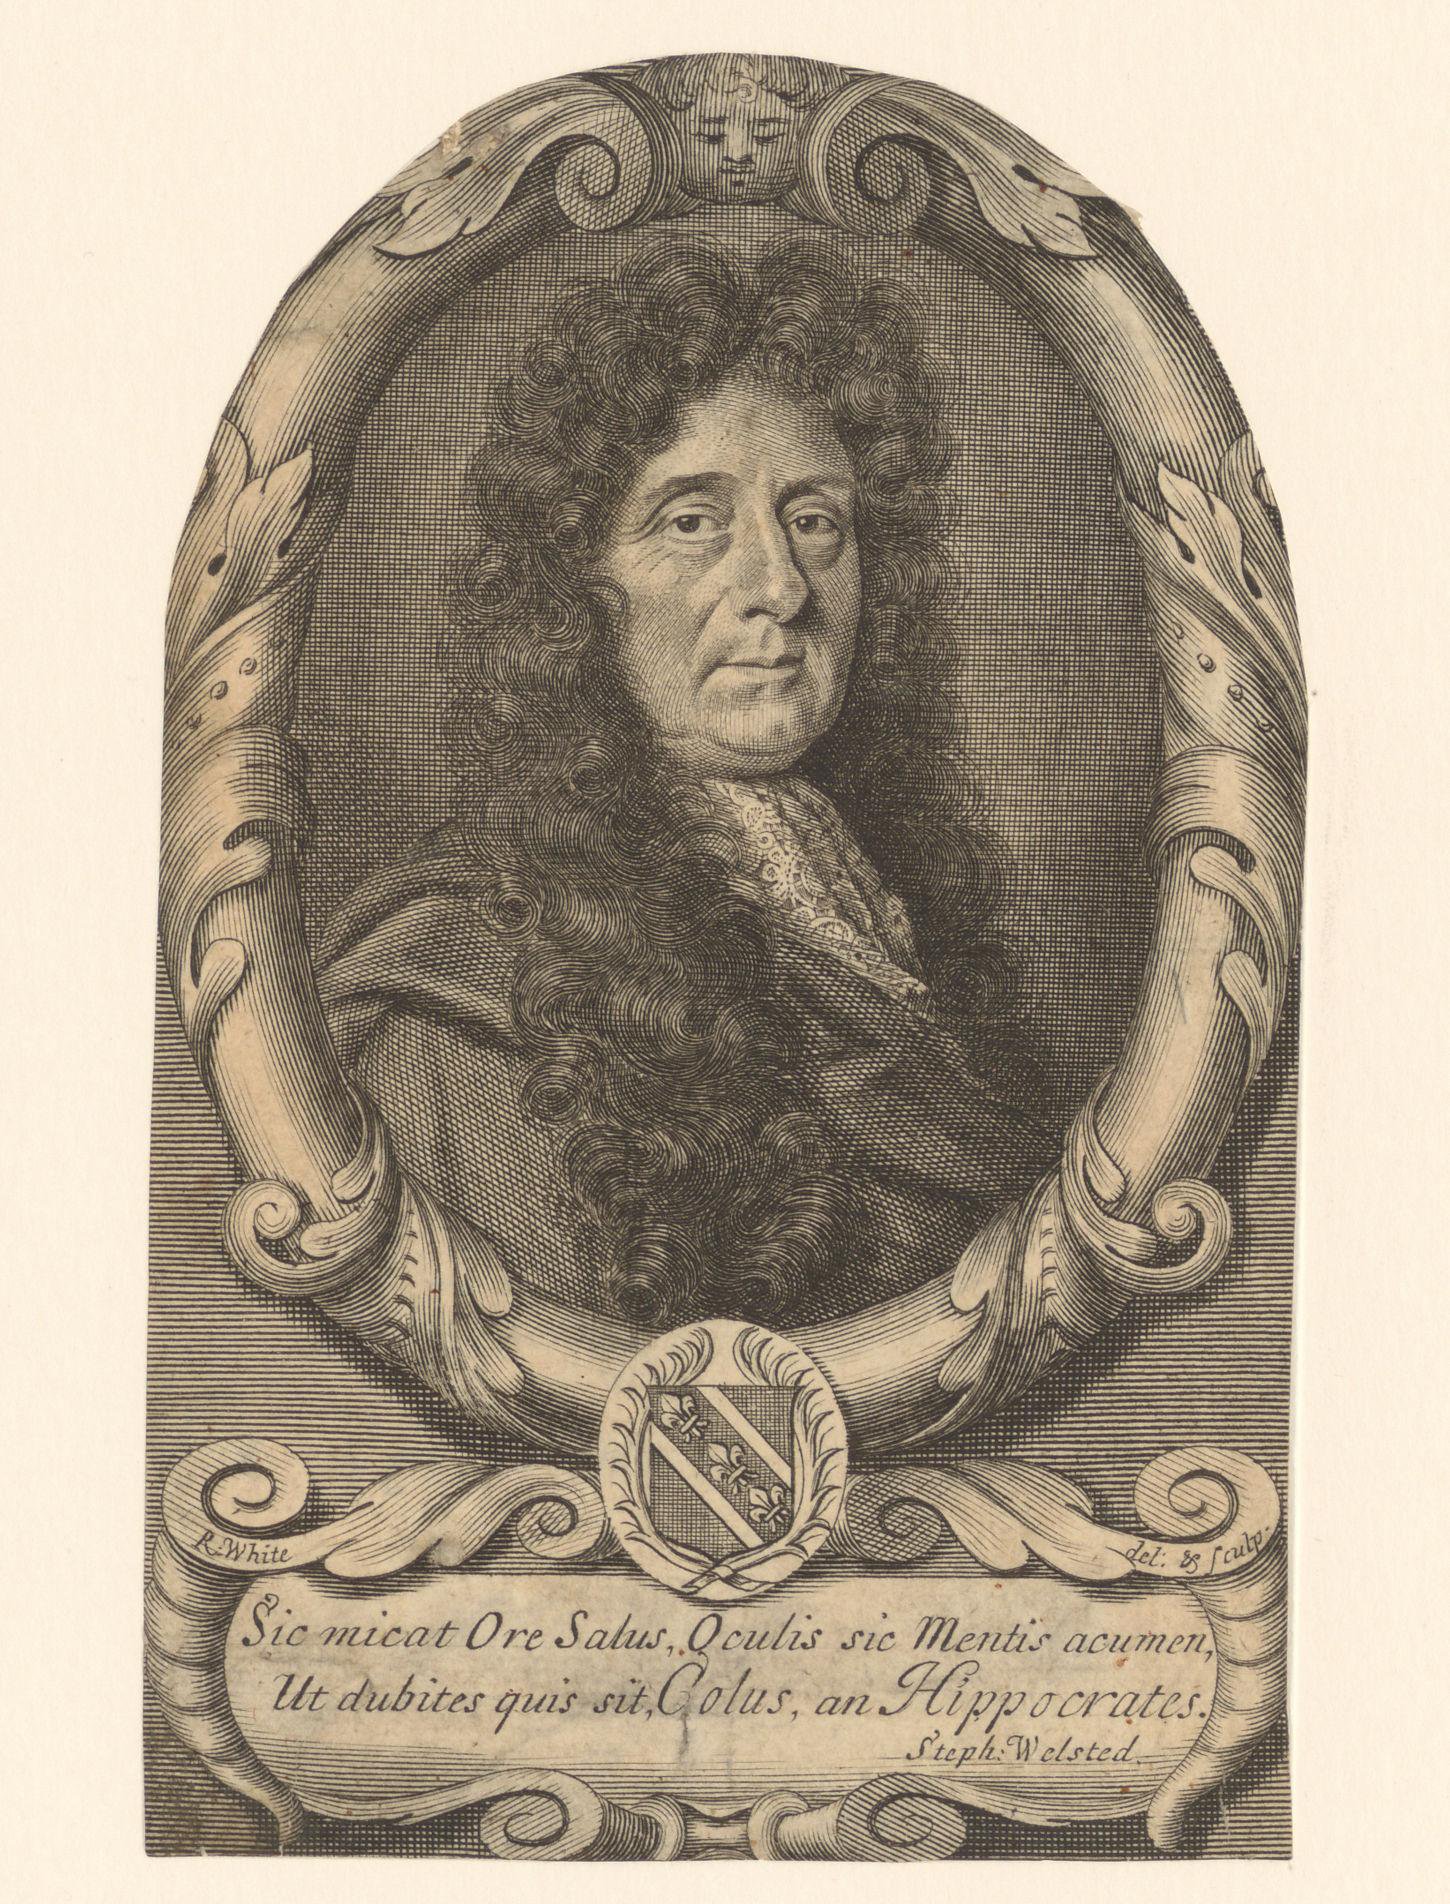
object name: print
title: Portret van William Cole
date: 1689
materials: paper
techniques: engraving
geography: london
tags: historical persons, physician, doctor (+ portrait of scholar, scientist)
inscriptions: collector's mark: Lugt 2228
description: Volgens O'Donoghue is de prent gebruikt in Cole's 'Treatise on Apoplexies', uit 1689.